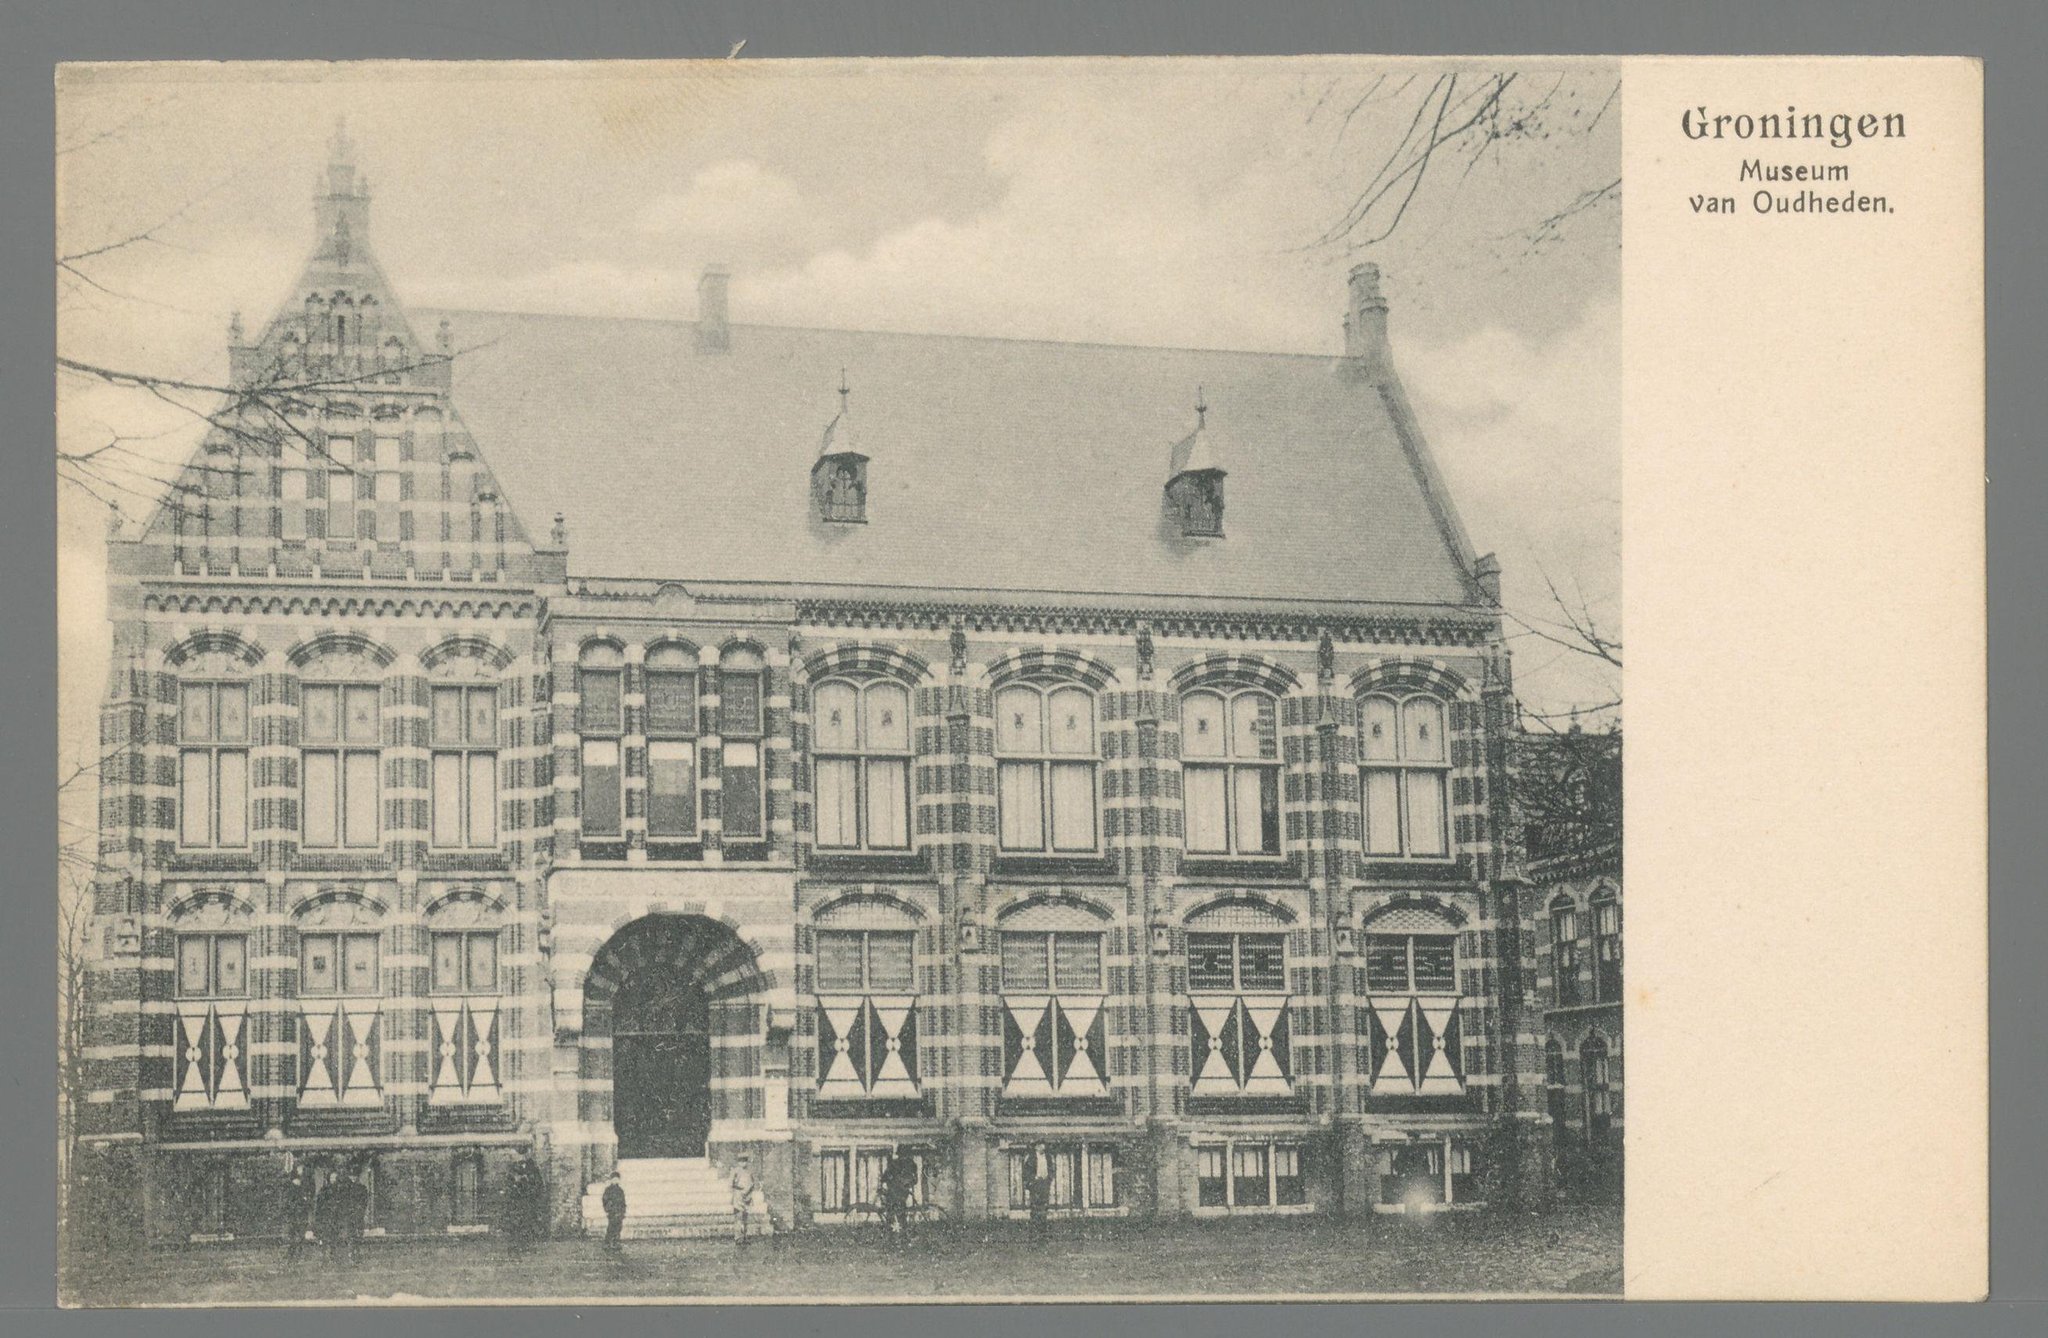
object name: photomechanical print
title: Groningen. Museum van Oudheden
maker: Anonymous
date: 1897-1905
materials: cardboard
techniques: photograph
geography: groningen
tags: permanent exhibition, museum